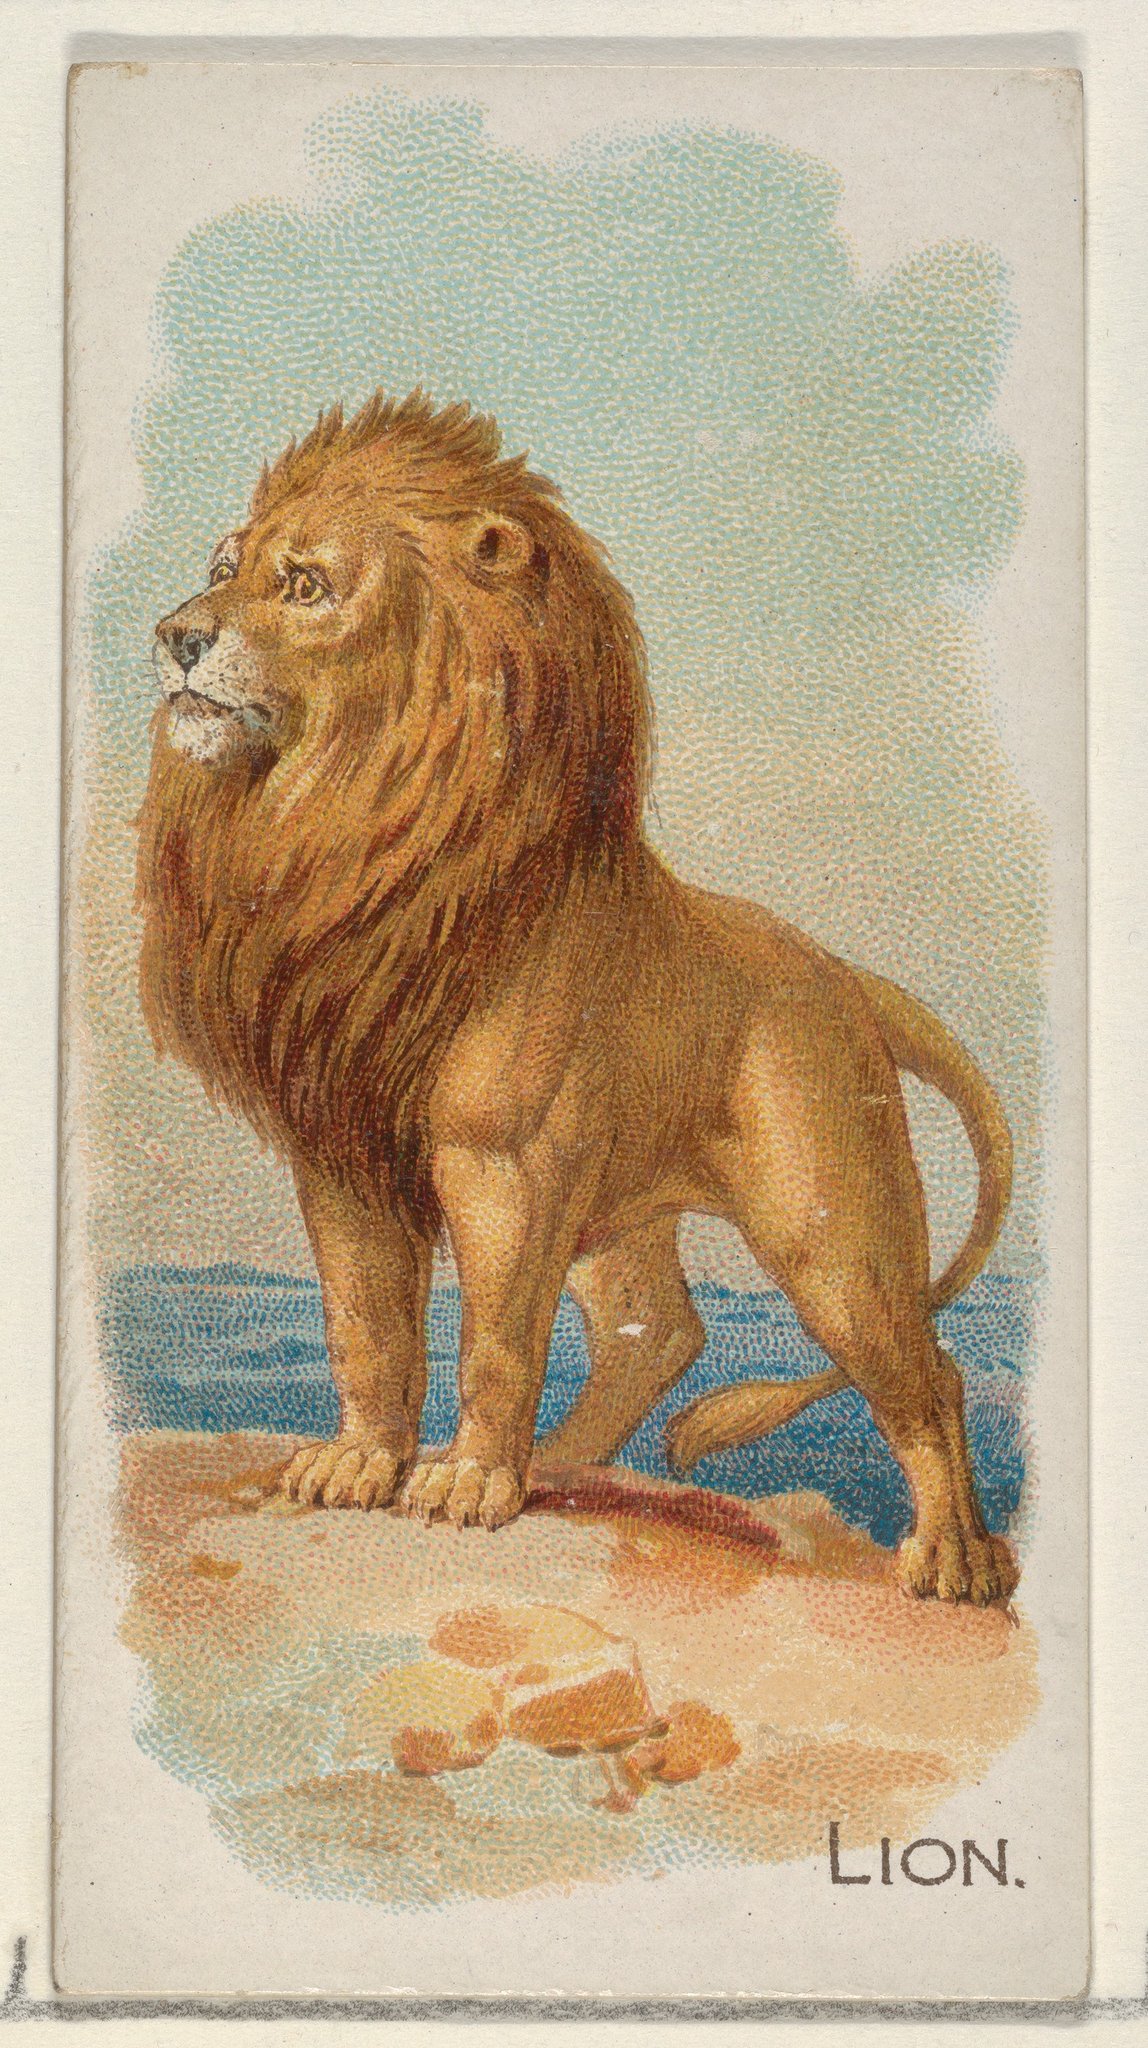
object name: print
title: Lion, from the Quadrupeds series (N21) for Allen & Ginter Cigarettes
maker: allen & ginter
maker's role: publisher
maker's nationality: american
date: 1890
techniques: color lithograph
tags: lions